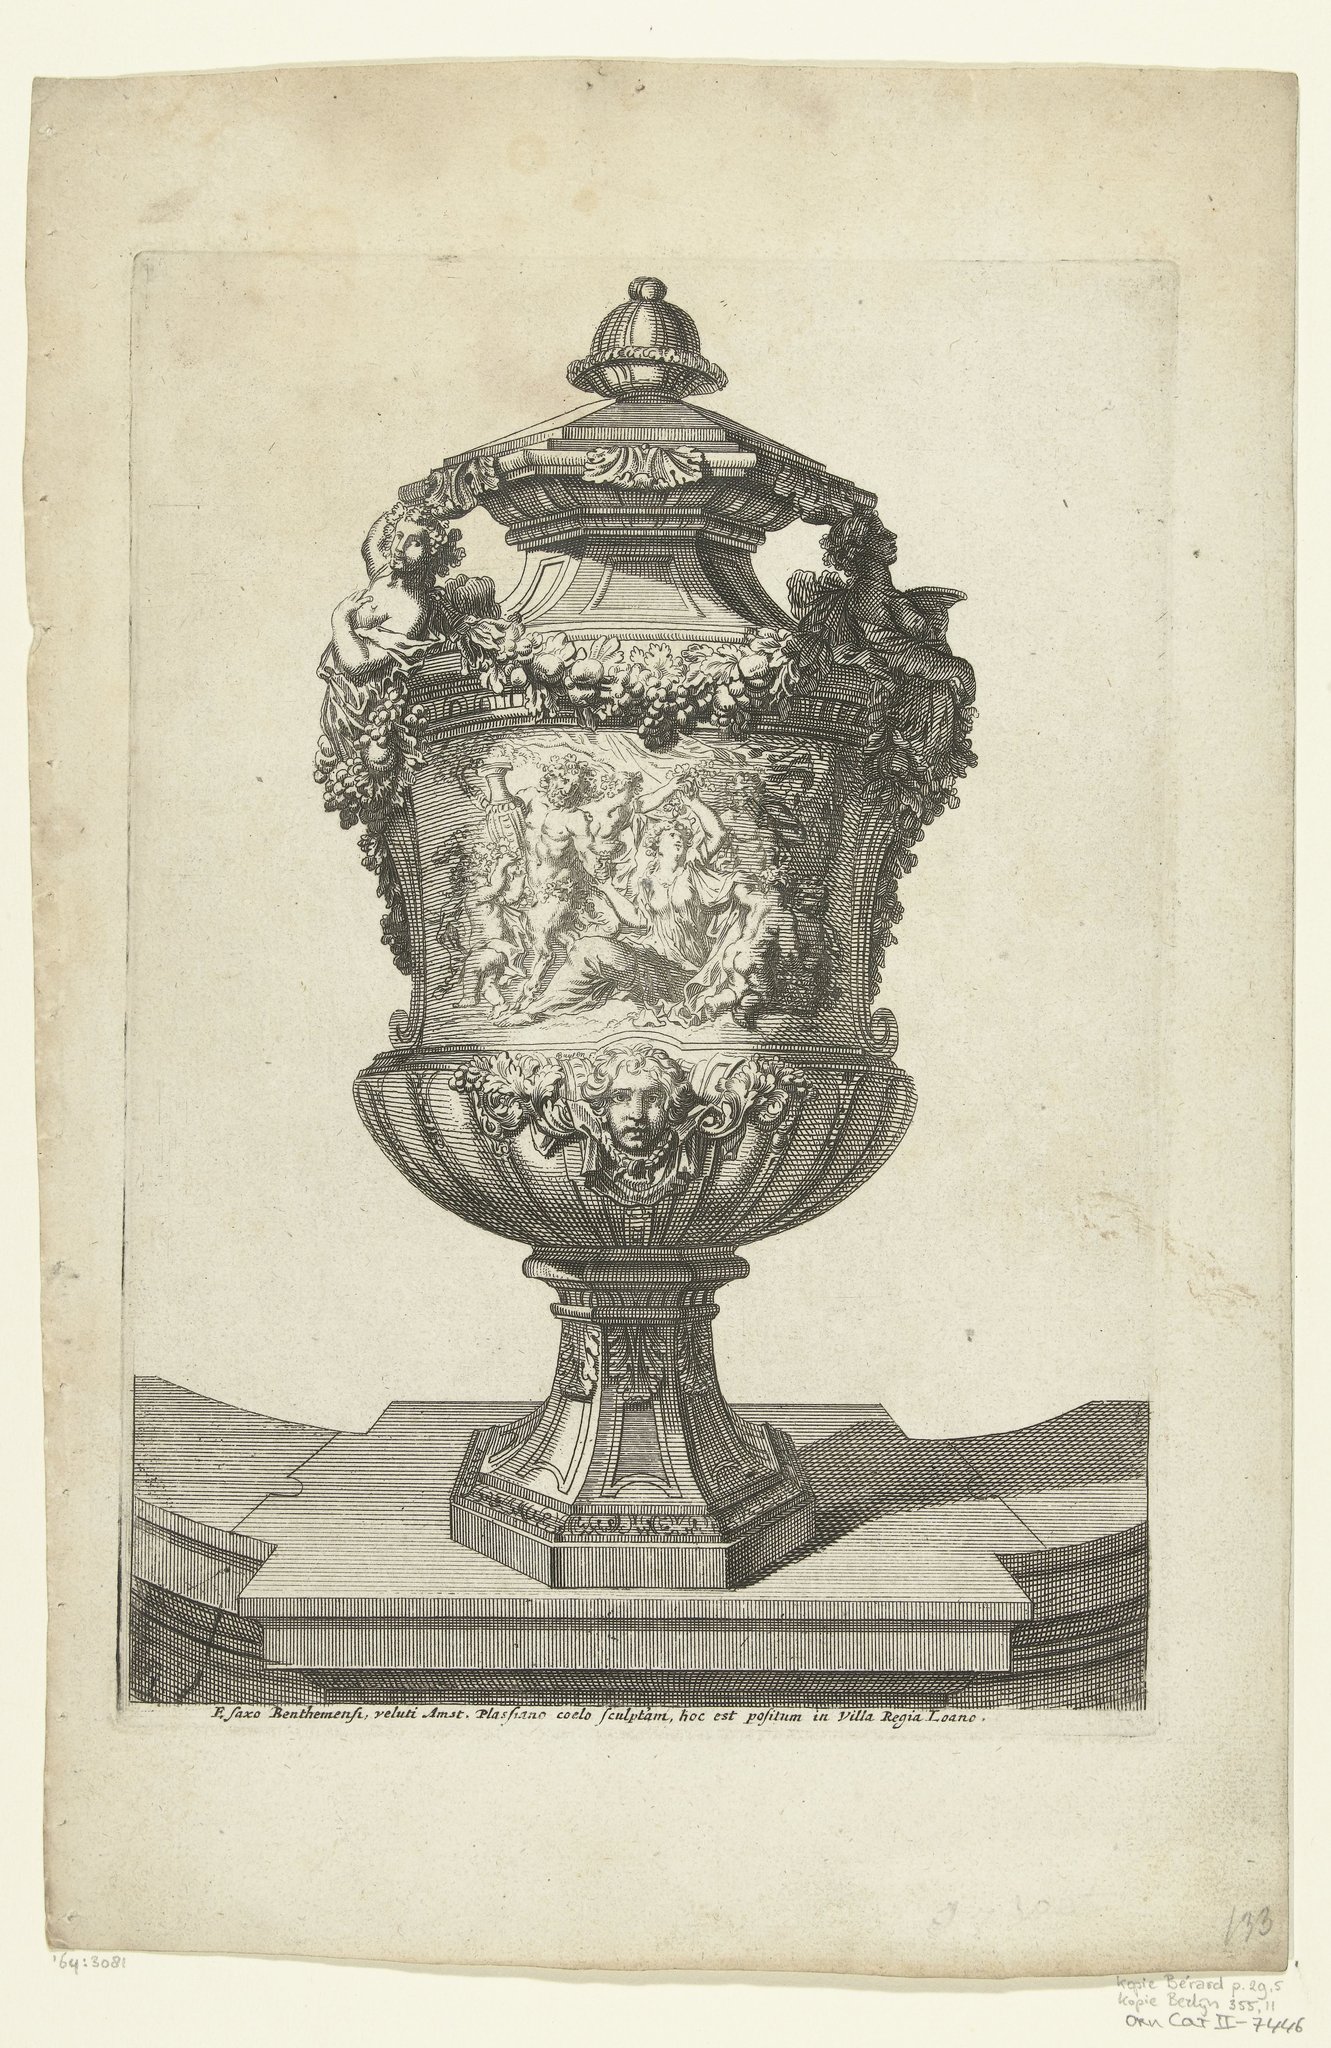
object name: print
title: Vaas met Bacchanaal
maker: Anonymous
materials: paper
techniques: etching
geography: netherlands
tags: bacchanal: bacchus with his wine-flushed train (thiasos), garden vase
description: Vaas op een achthoekige voet met handvatten in de vorm van nimfen. Op het lichaam van de vaas een Bacchanaal. In de ondermarge een Latijnse tekst. Kopie naar blad uit de serie Vasses de la Maison Royalle de L'oo. Uit serie van 6 bladen.